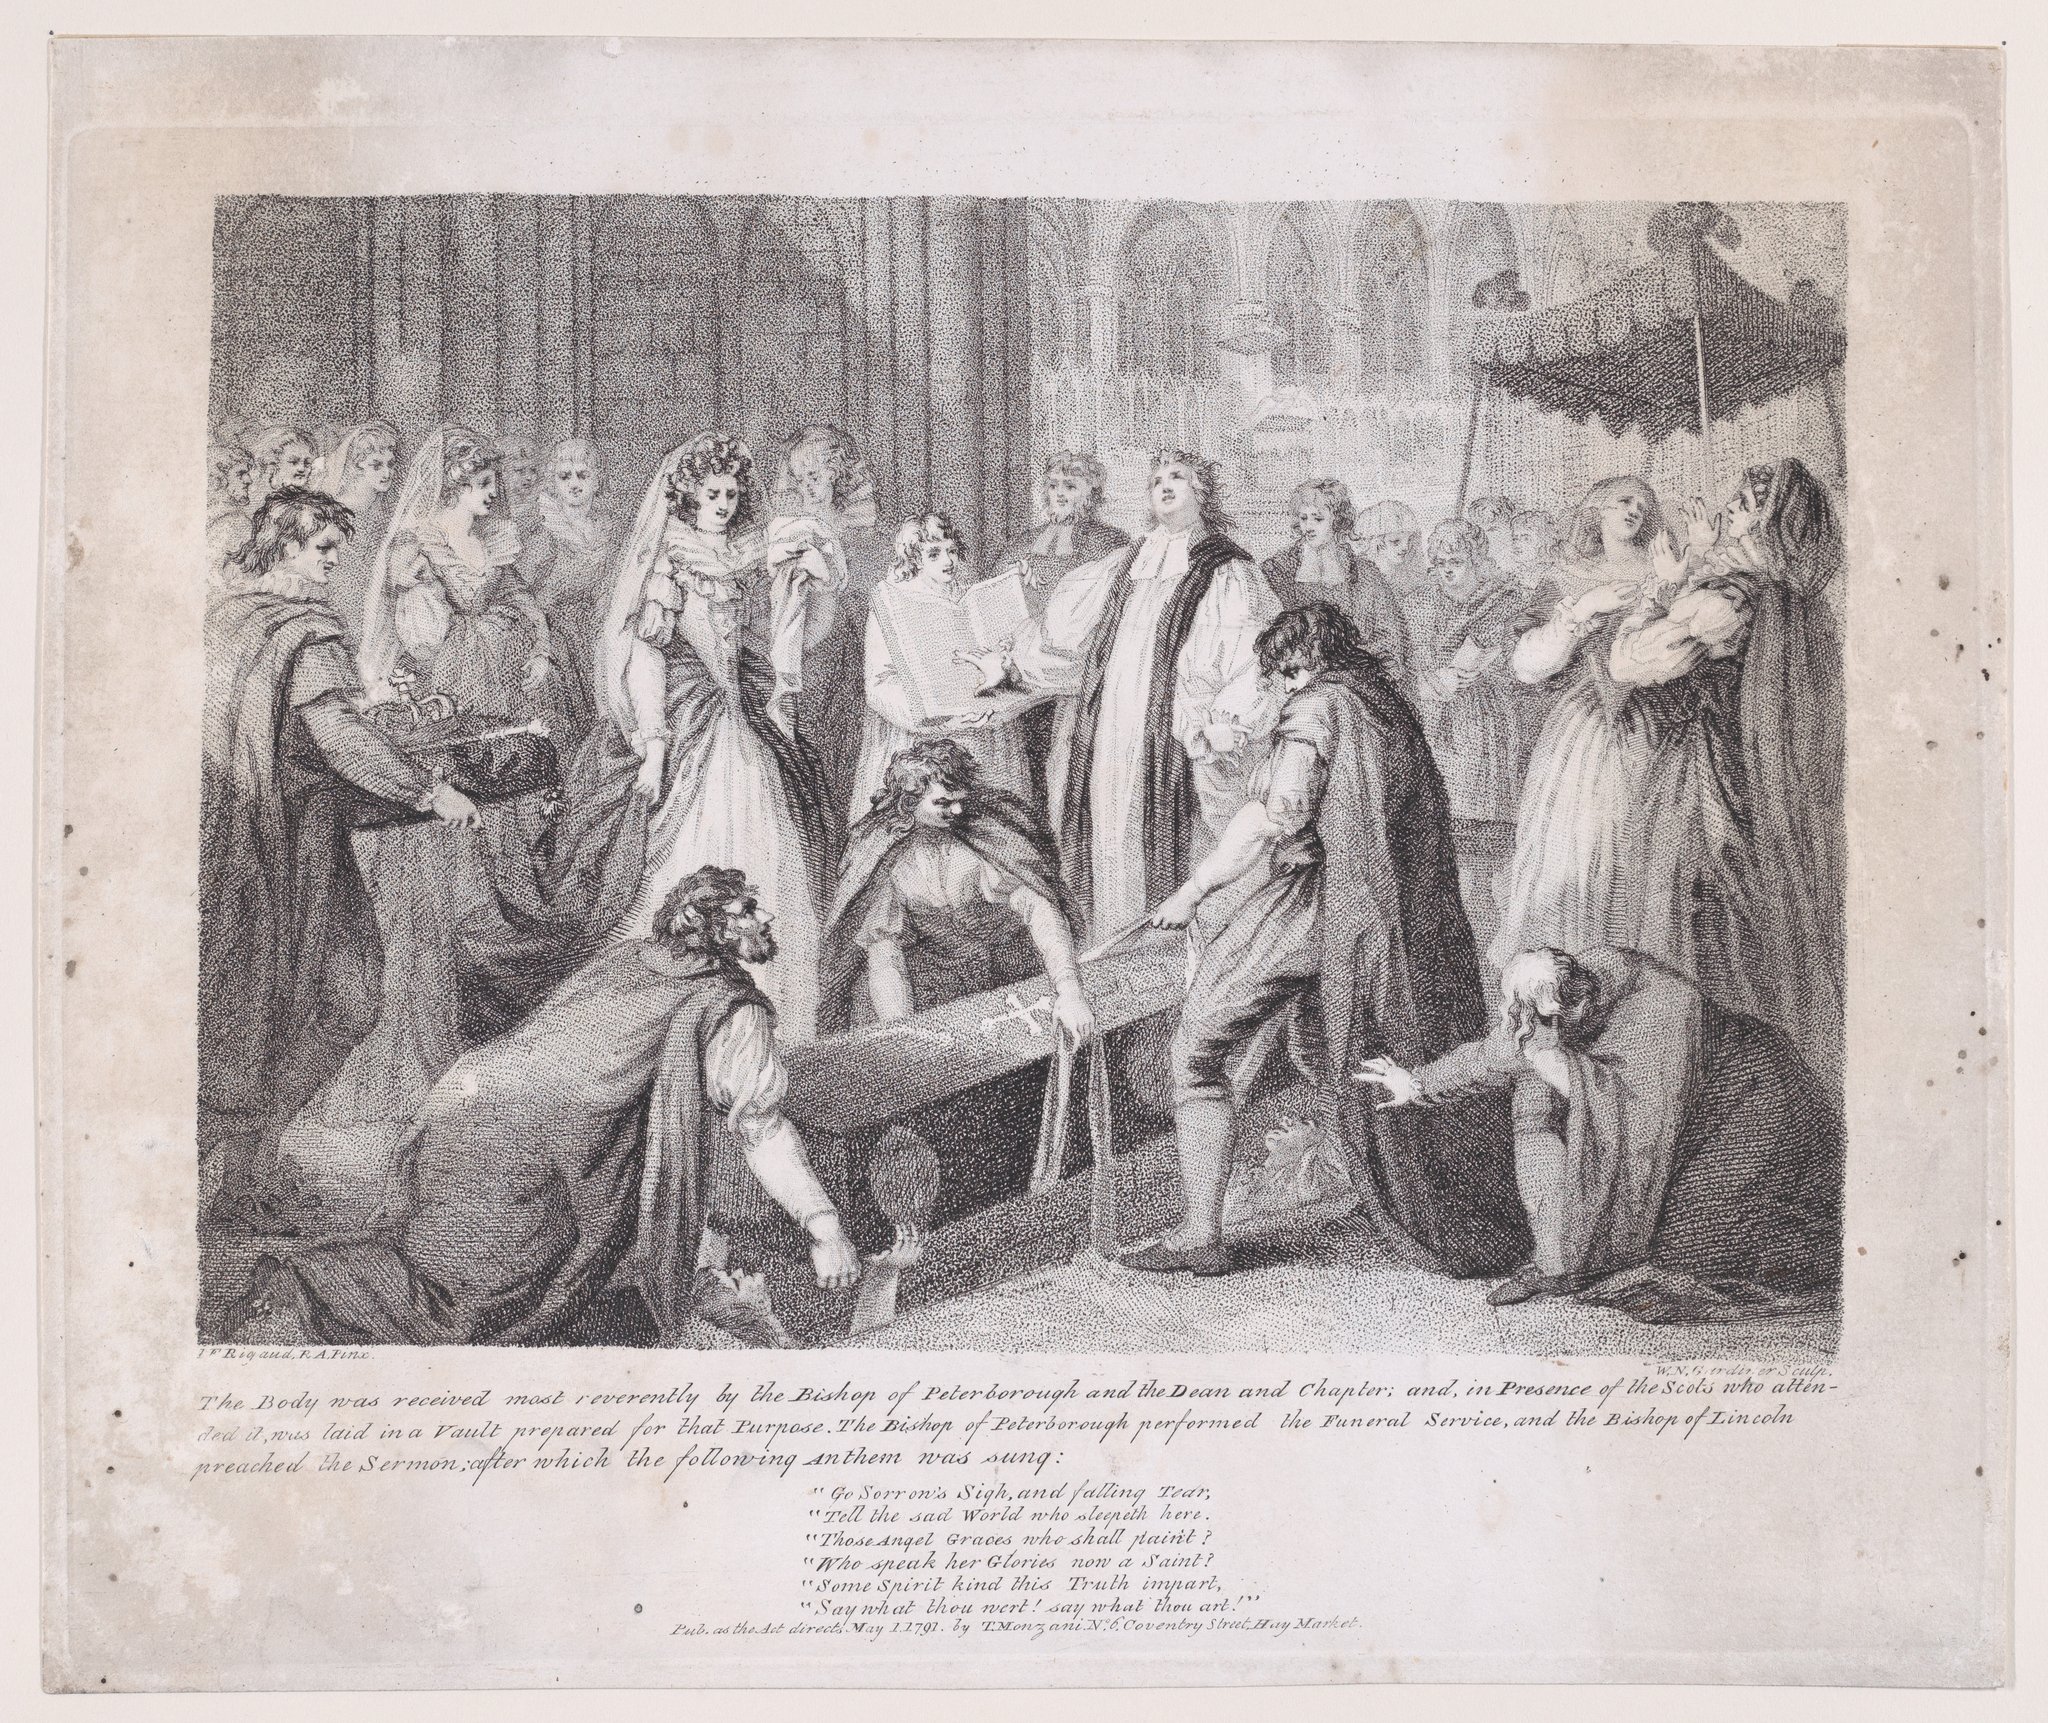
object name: print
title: The Internment of Mary, Queen of Scots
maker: william nelson gardiner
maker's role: artist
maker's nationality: british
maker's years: 1766-1814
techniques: engraving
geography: england